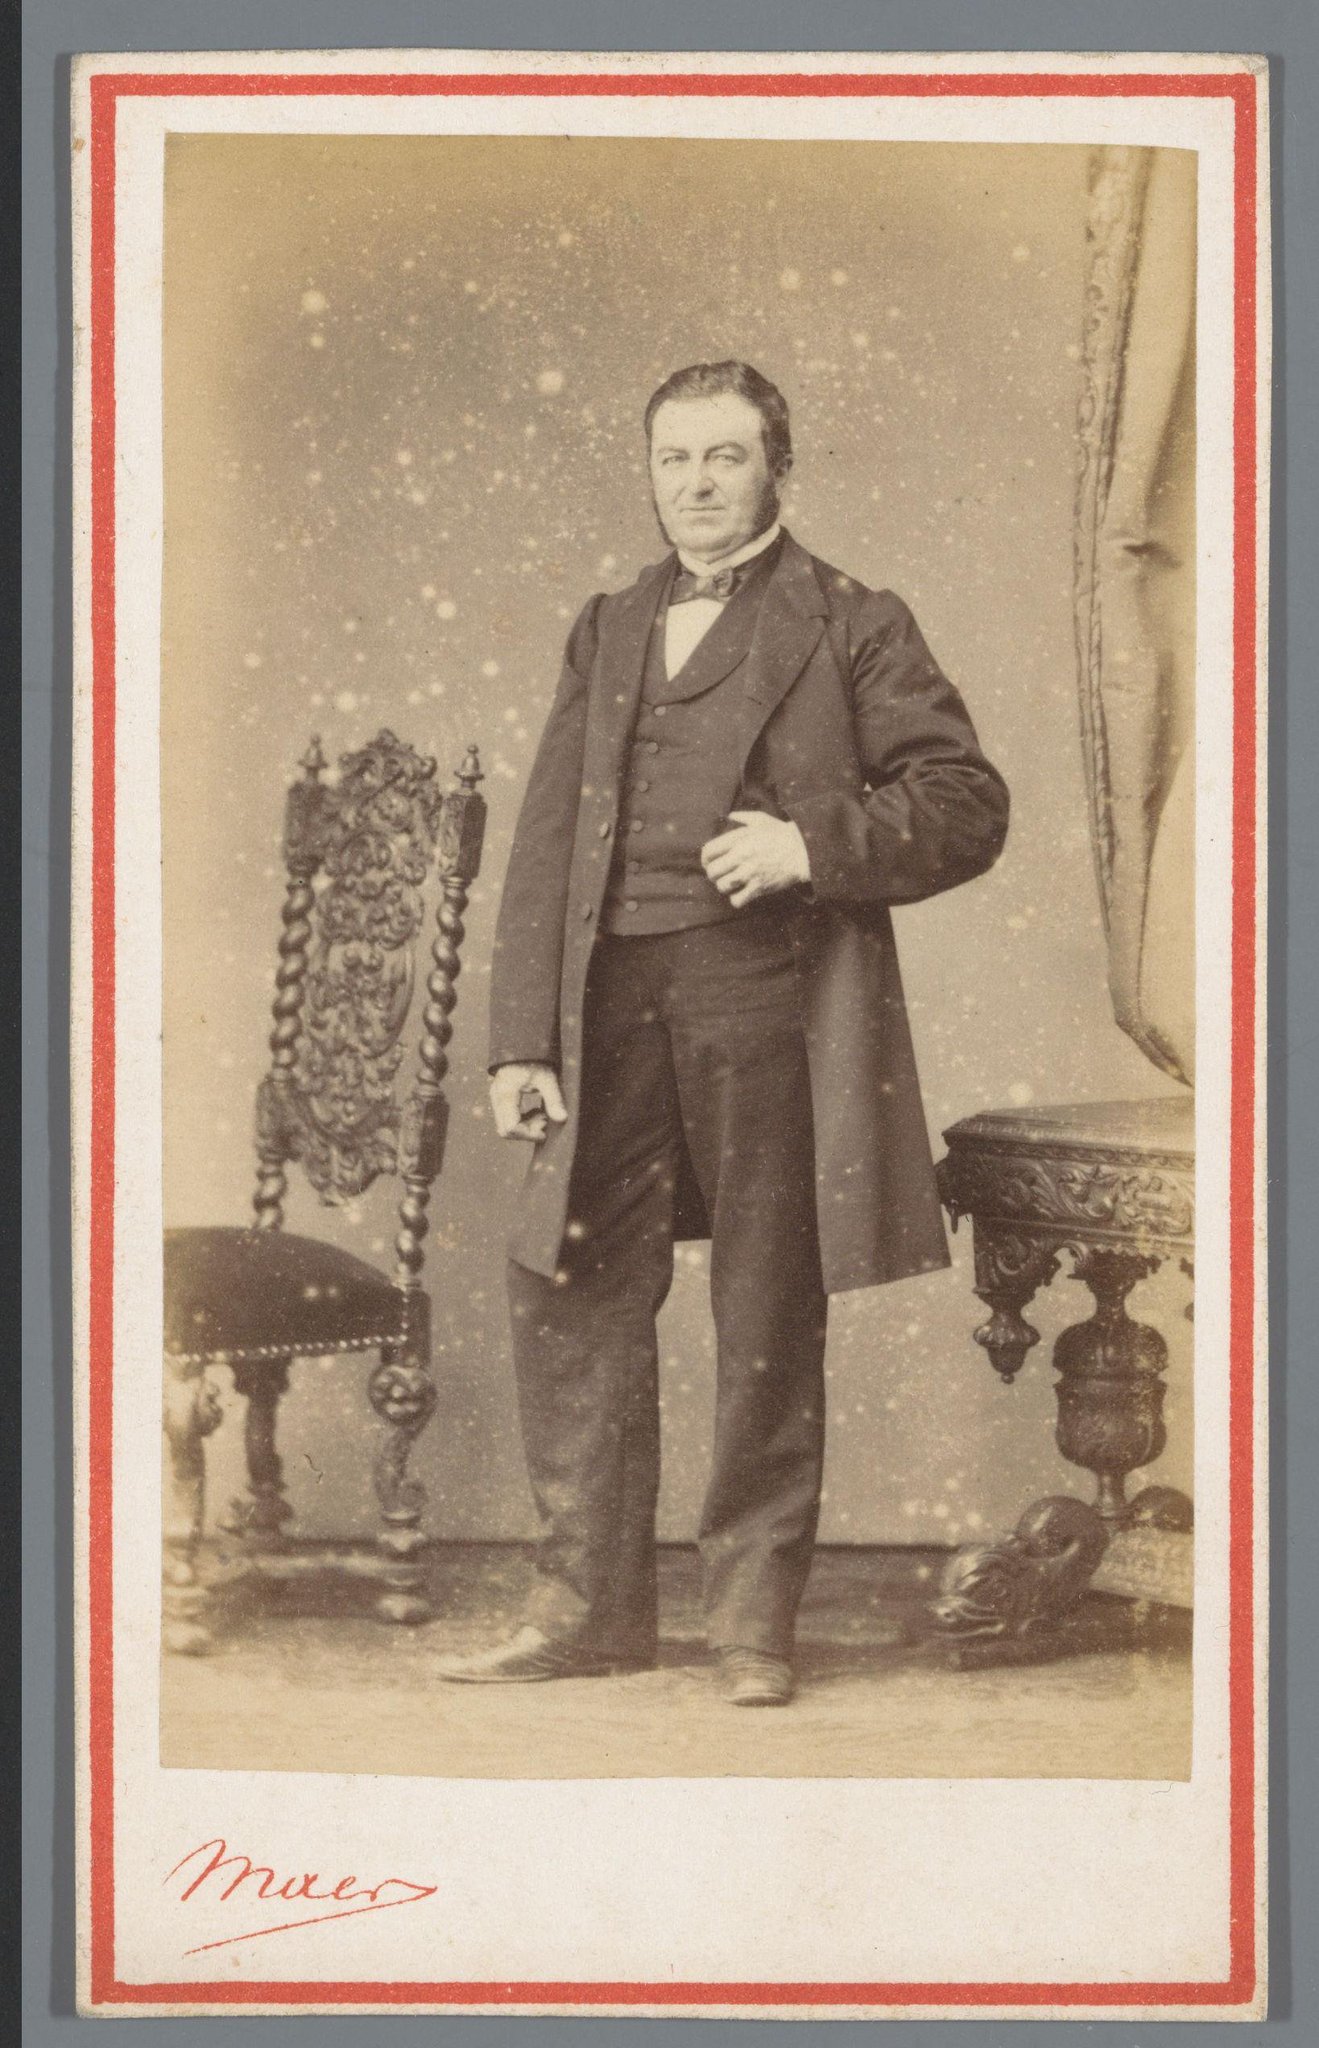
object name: carte de visite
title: Portret van een onbekende man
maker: joseph maes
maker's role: fotograaf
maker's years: 1838-1908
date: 1863-1866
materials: cardboard, paper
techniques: albumen print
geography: brussels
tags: adult man, anonymous historical person portrayed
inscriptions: address: ‘Place de la Monnaie/ 36, Rue Fossé-aux-Loups./ BRUXELLES.’